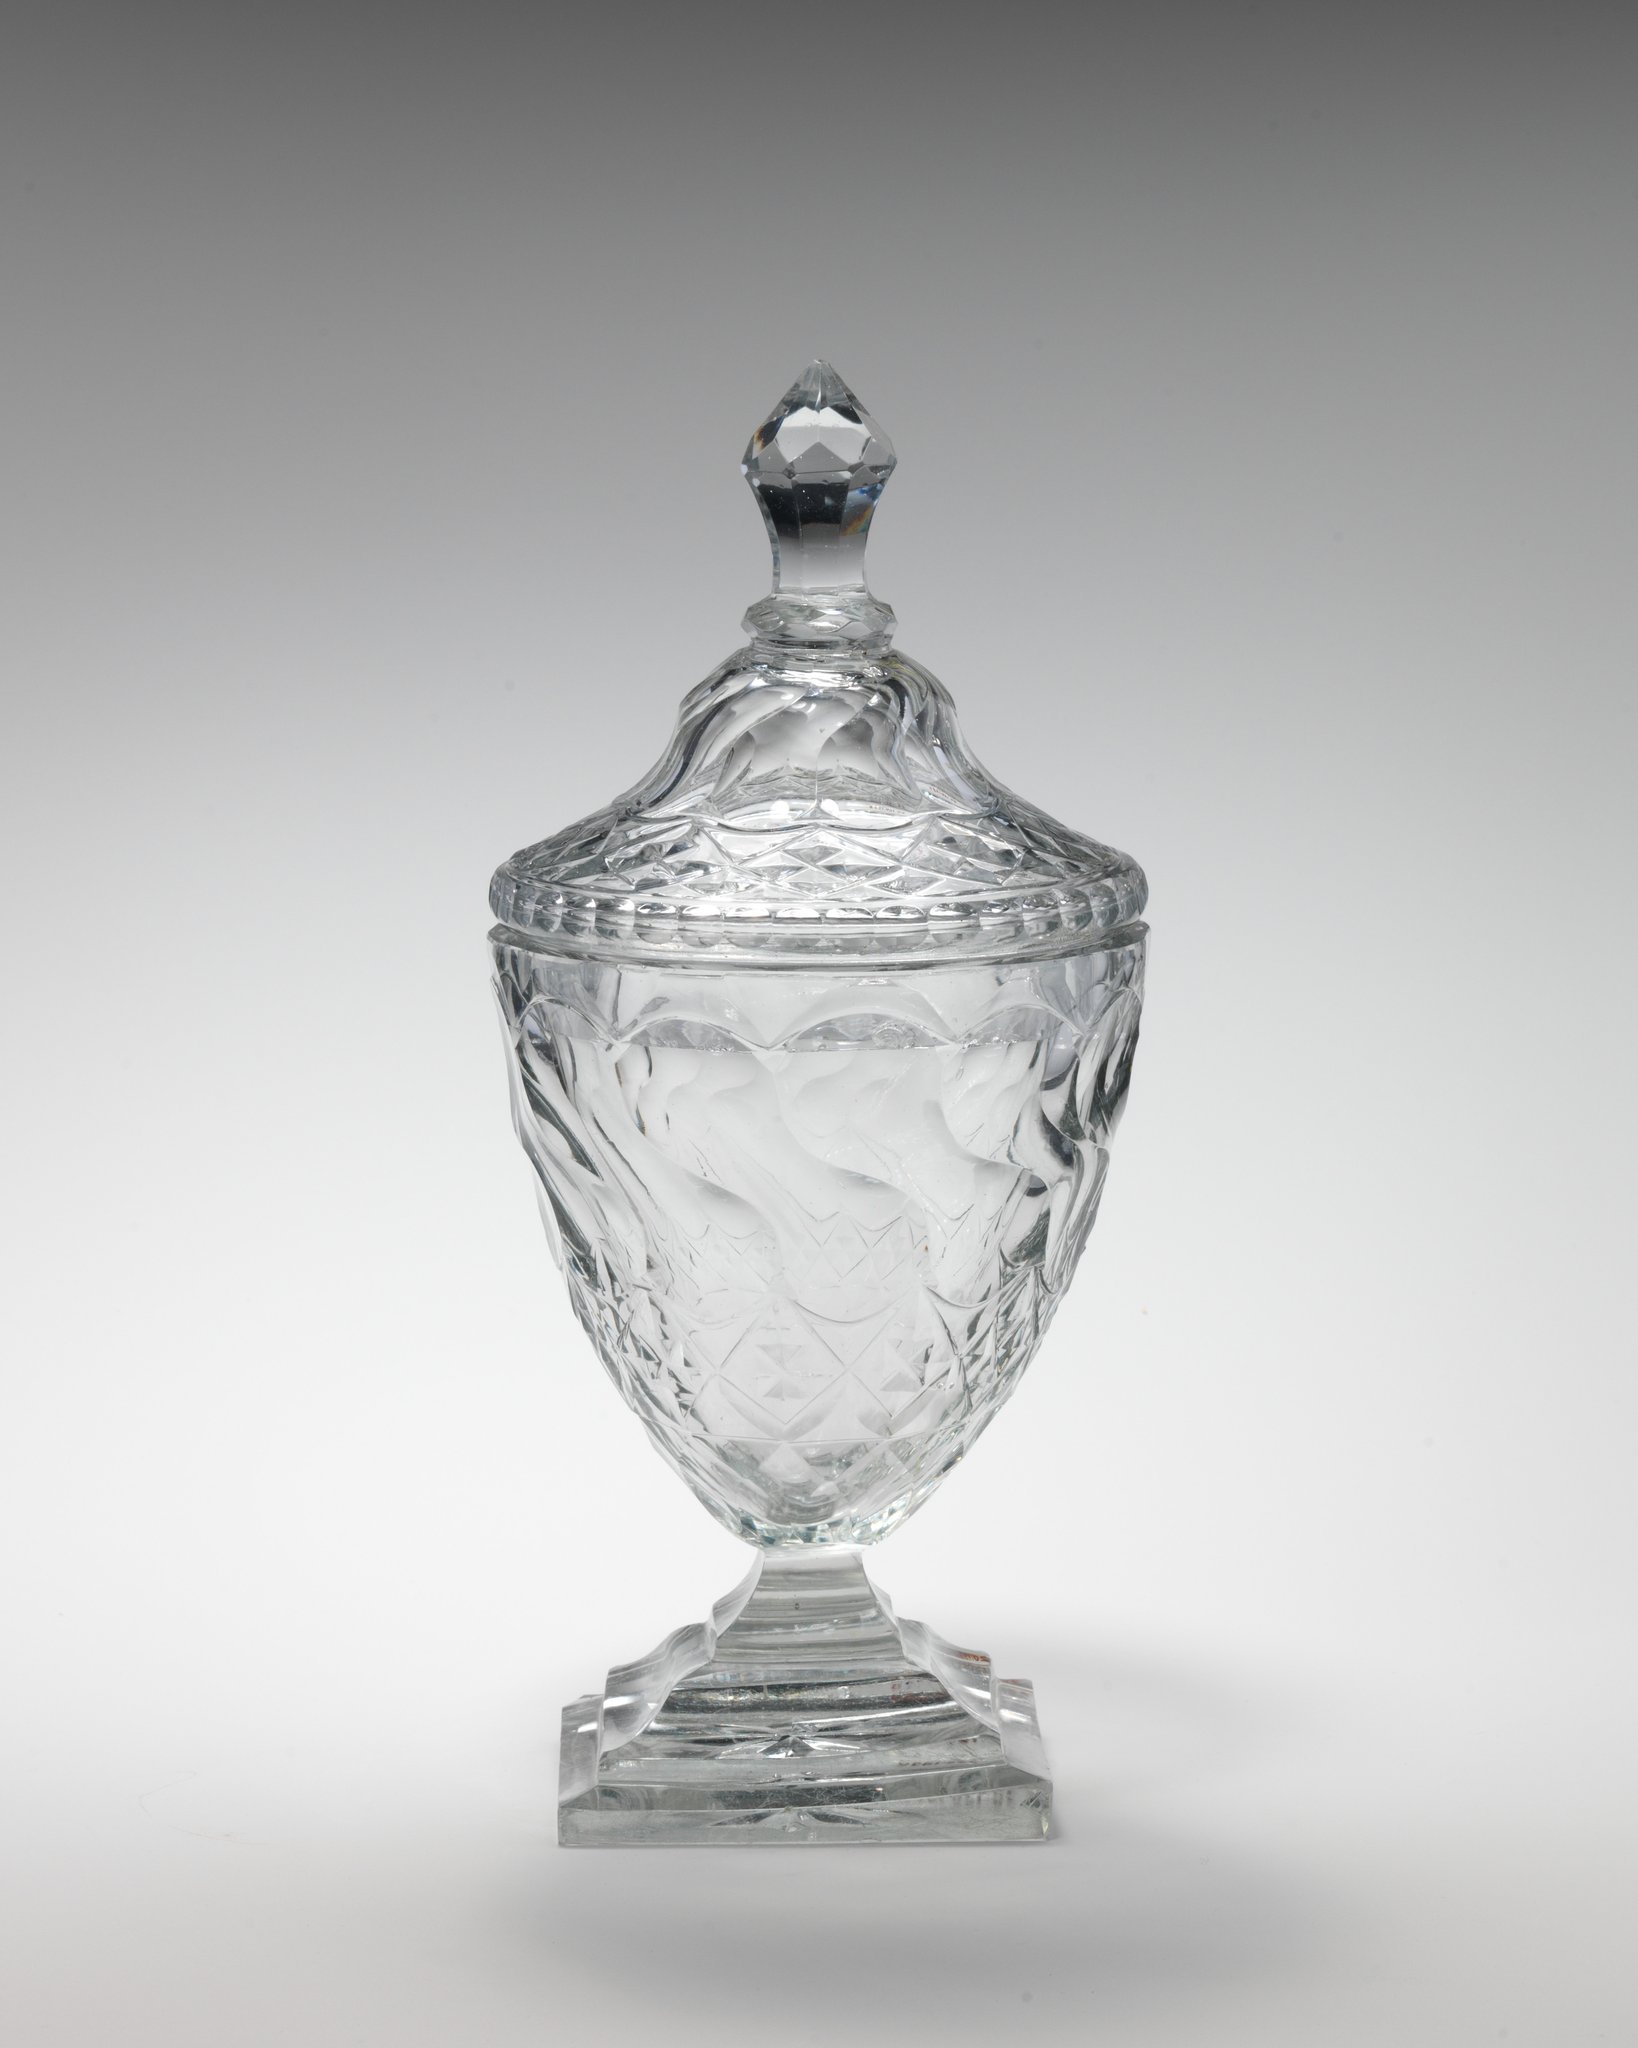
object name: urn with cover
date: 1834-1866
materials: glass